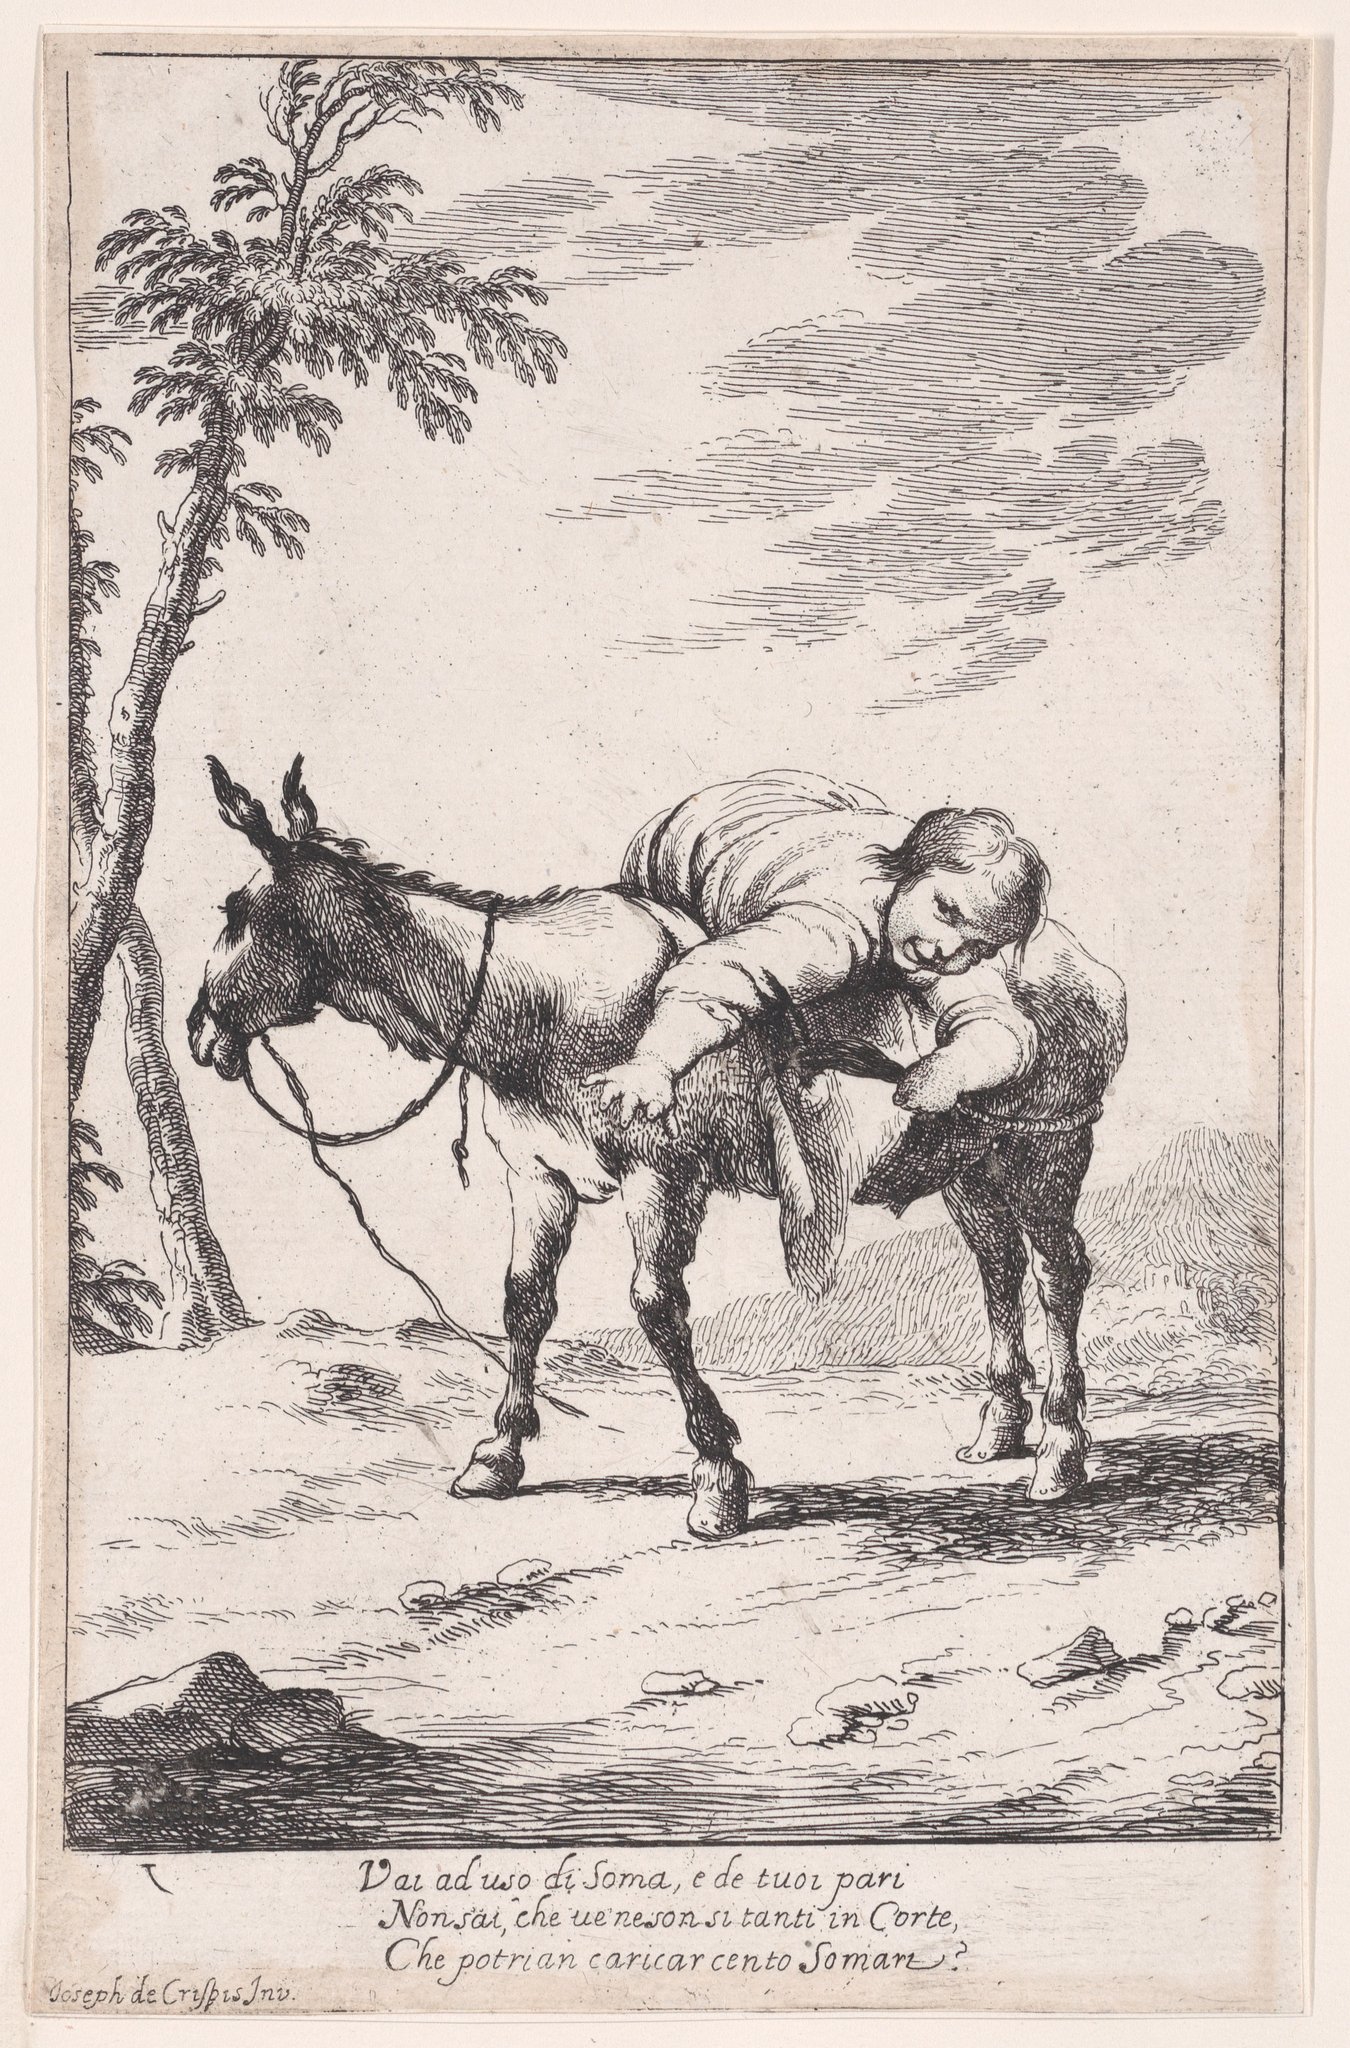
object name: print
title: Plate 7: Bertoldino lying on a donkey, from "Bertoldo, Bertoldino, and Cacasenno"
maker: giuseppe maria crespi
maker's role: artist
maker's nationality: italian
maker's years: 1665-1747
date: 1705-1715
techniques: etching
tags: boys,donkeys